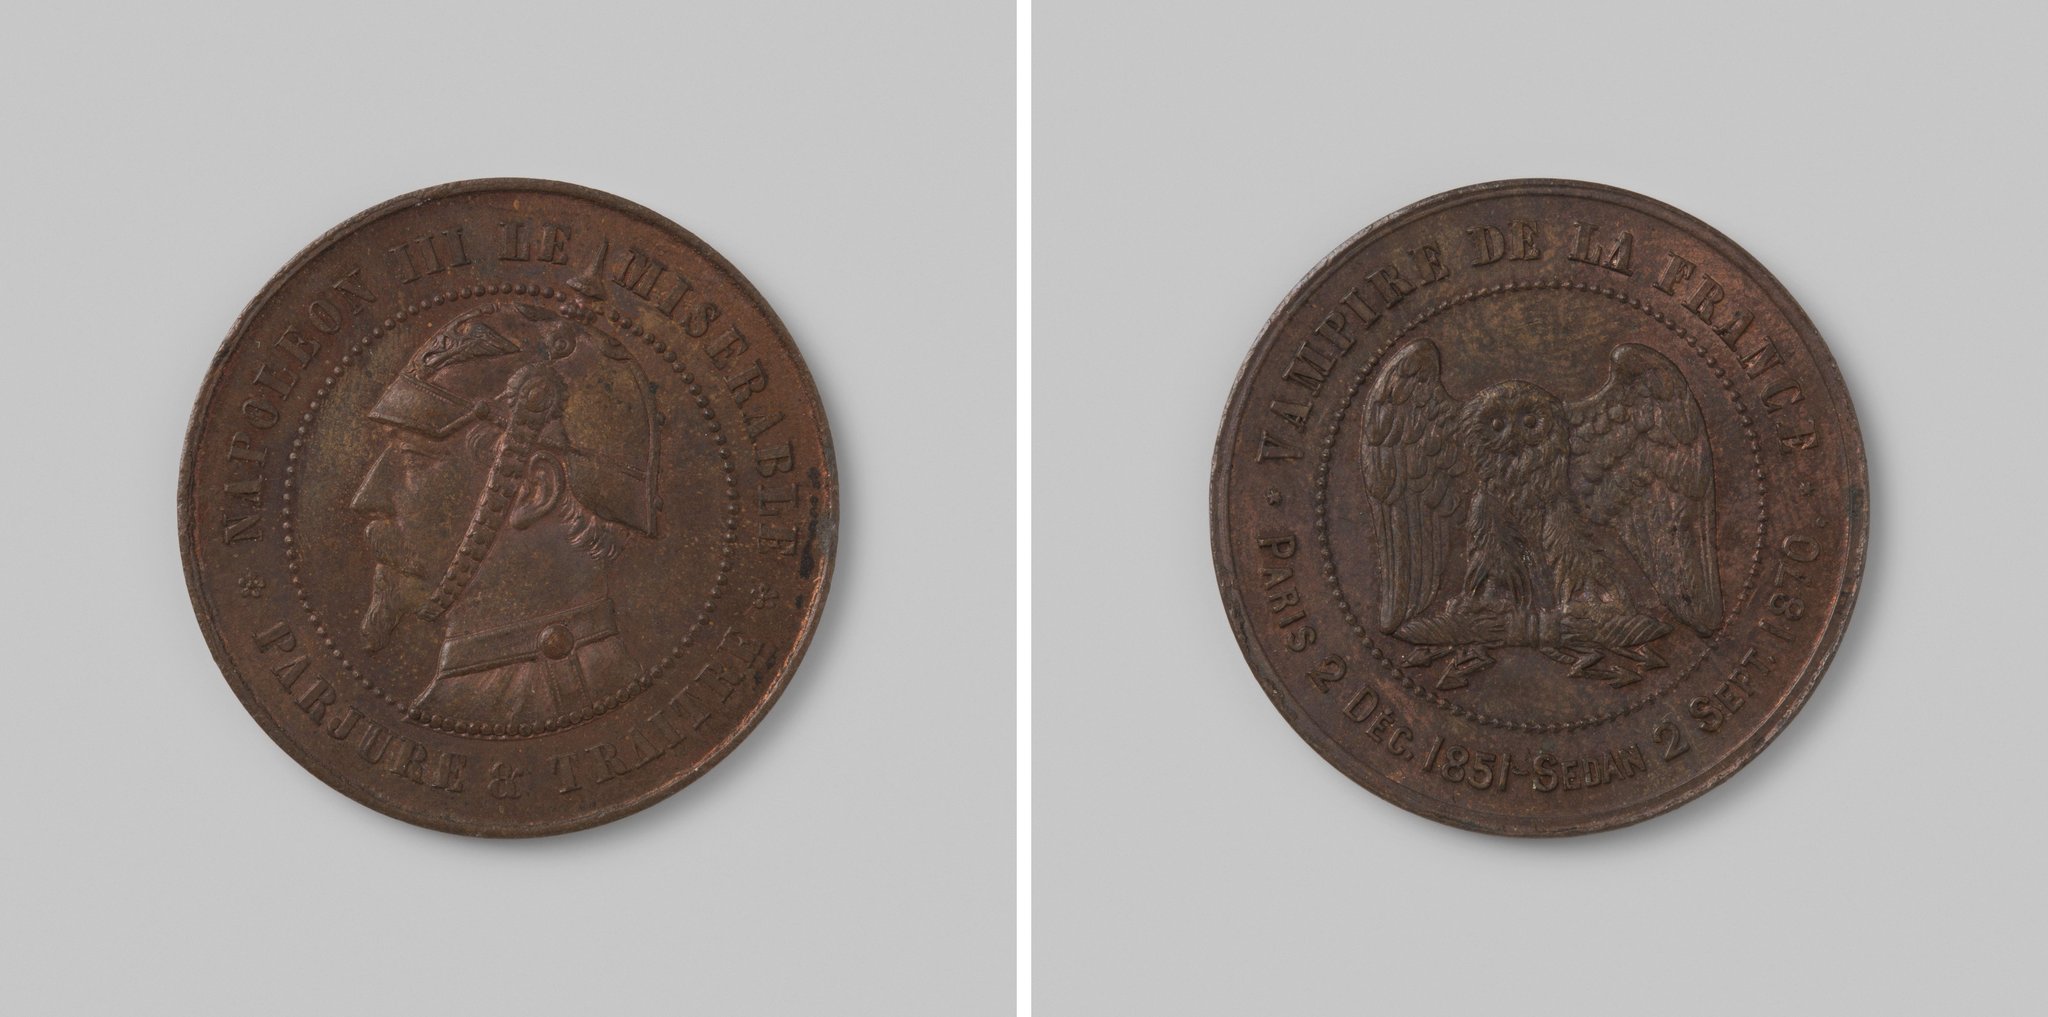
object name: history medal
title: Napoleon III de Miserabele, vampier van Frankrijk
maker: Anonymous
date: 1870-1871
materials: copper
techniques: striking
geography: france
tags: paris, london, napoleon iii (keizer der fransen)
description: Koperen penning. Voorzijde: borststuk man met Duitse 'Pickelhaube' binnen omschrift. Keerzijde: uil, zittend op bliksemschicht binnen omschrift